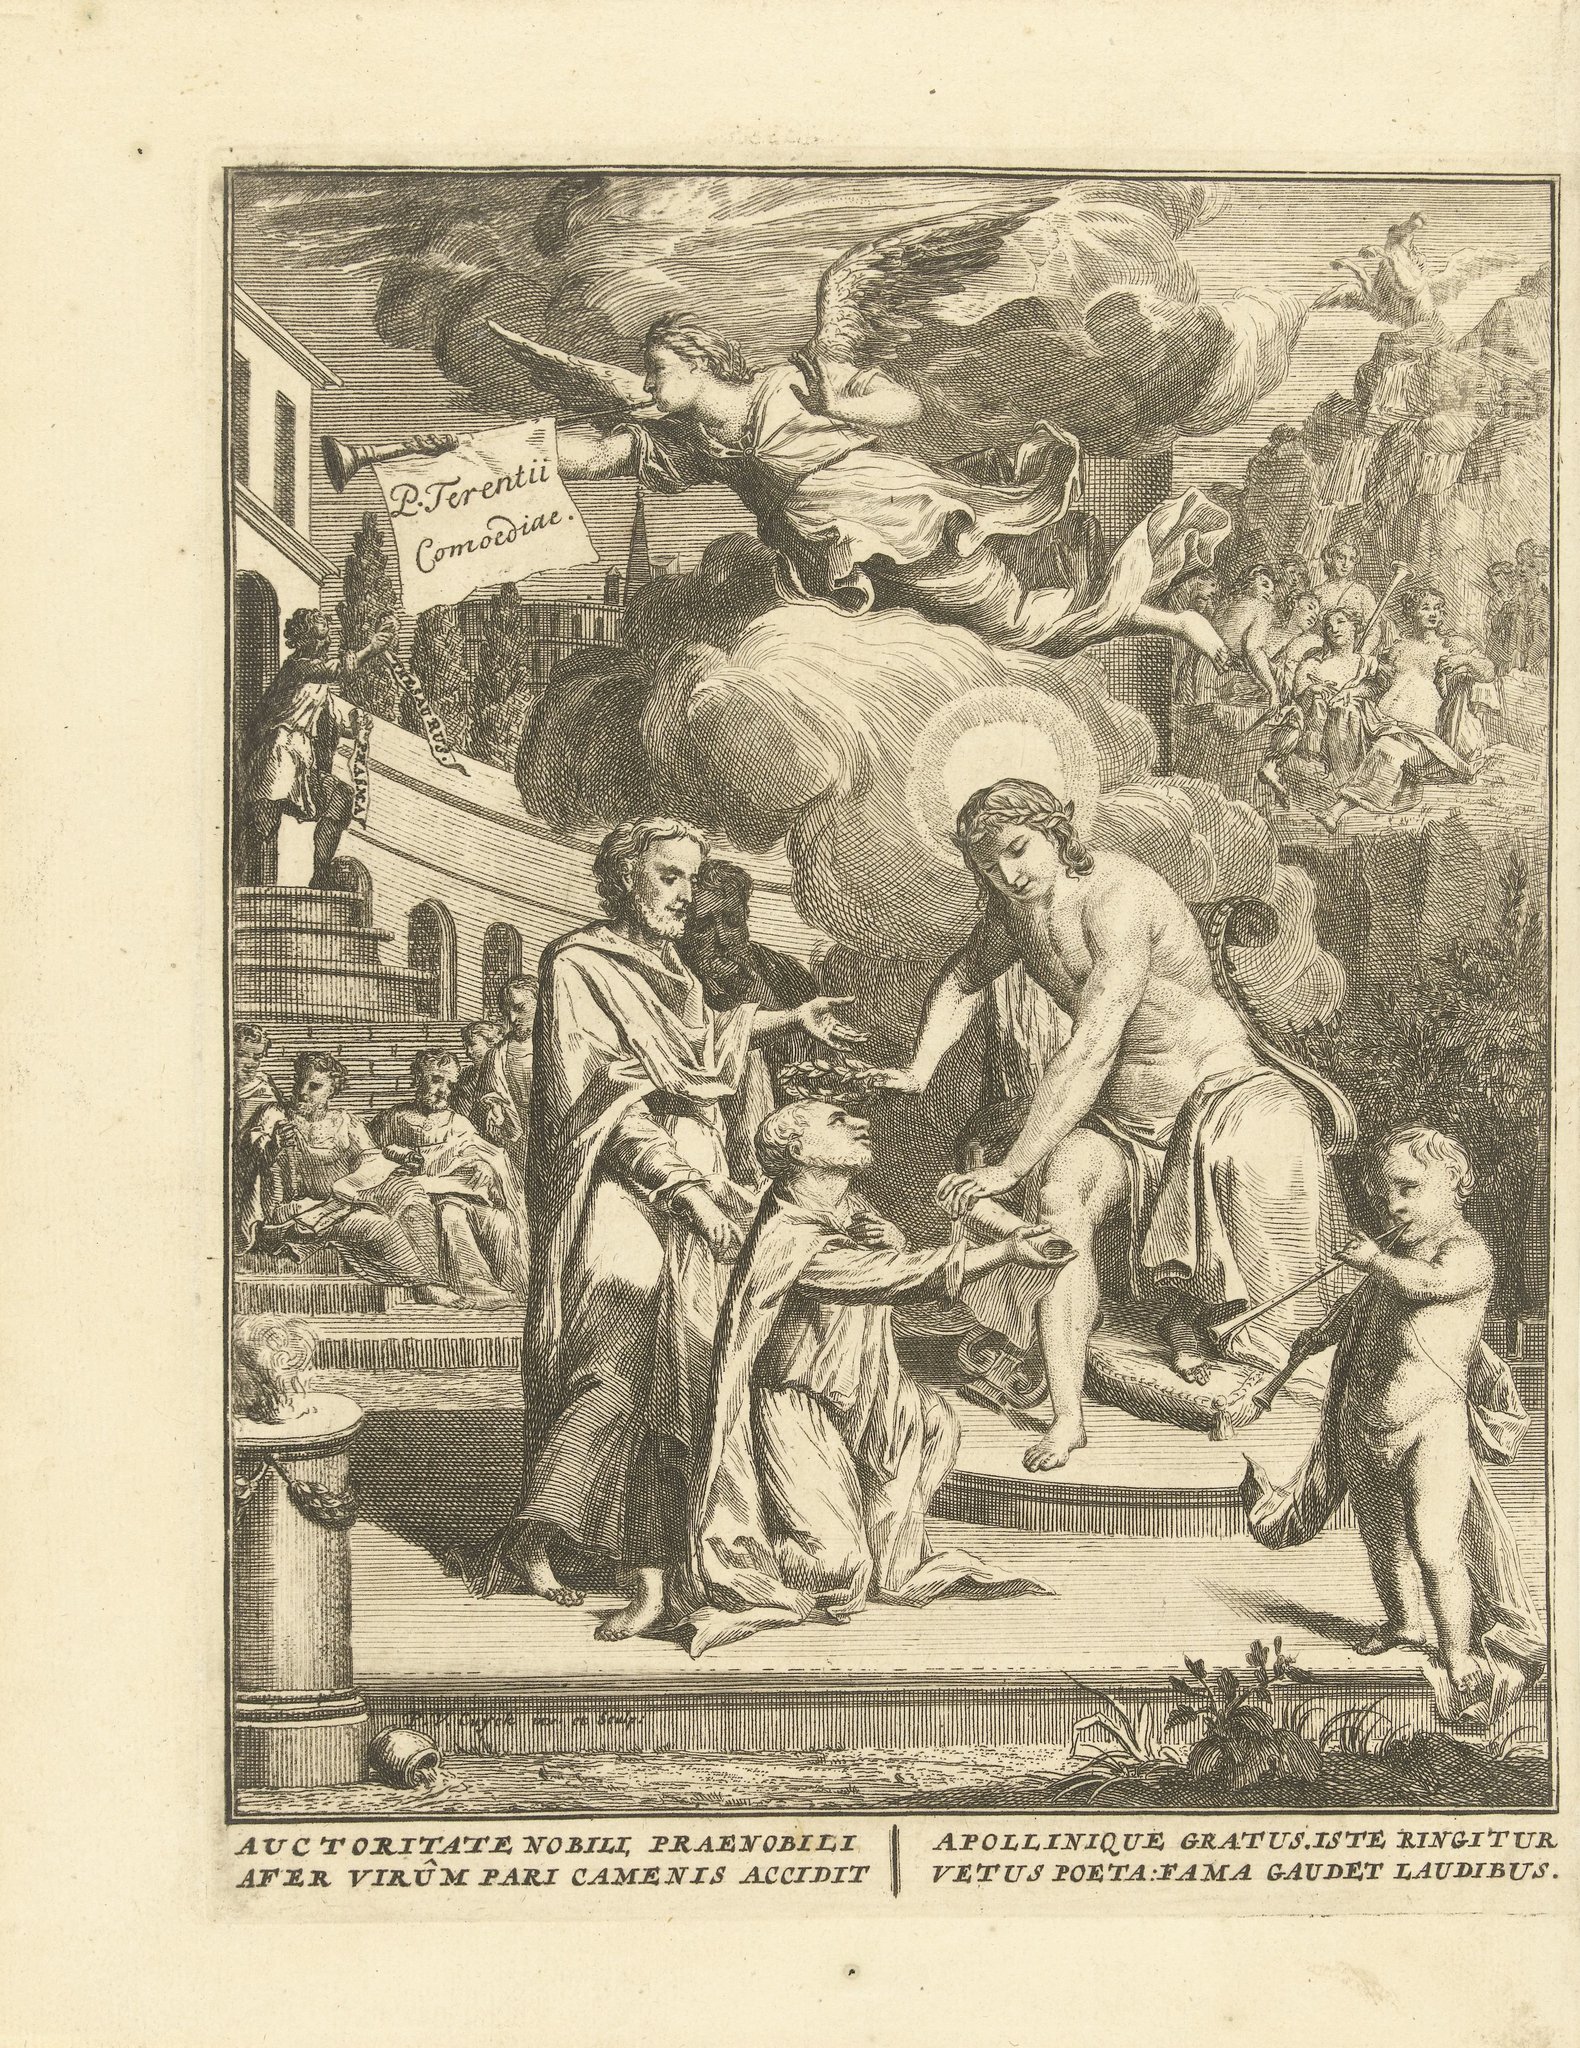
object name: book illustration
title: Allegorie met Apollo die schrijver Publius Terentius Afer eert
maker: pieter van cuyck (i)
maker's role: print maker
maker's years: 1689-1765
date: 1726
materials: paper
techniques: etching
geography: the hague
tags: apollo and the muses, apollo musagetes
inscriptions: collector's mark: Lugt 2228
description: Allegorie met Apollo die Latijnse schrijver Publius Terentius Afer eert. De schrijver neemt een schriftrol en lauwerkrans in ontvangst van de god terwijl een engel op een bazuin blaast en op de achtergrond geleerden en de muzen op de berg Parnassus toekijken. In de marge Latijns opschrift in vier regels.